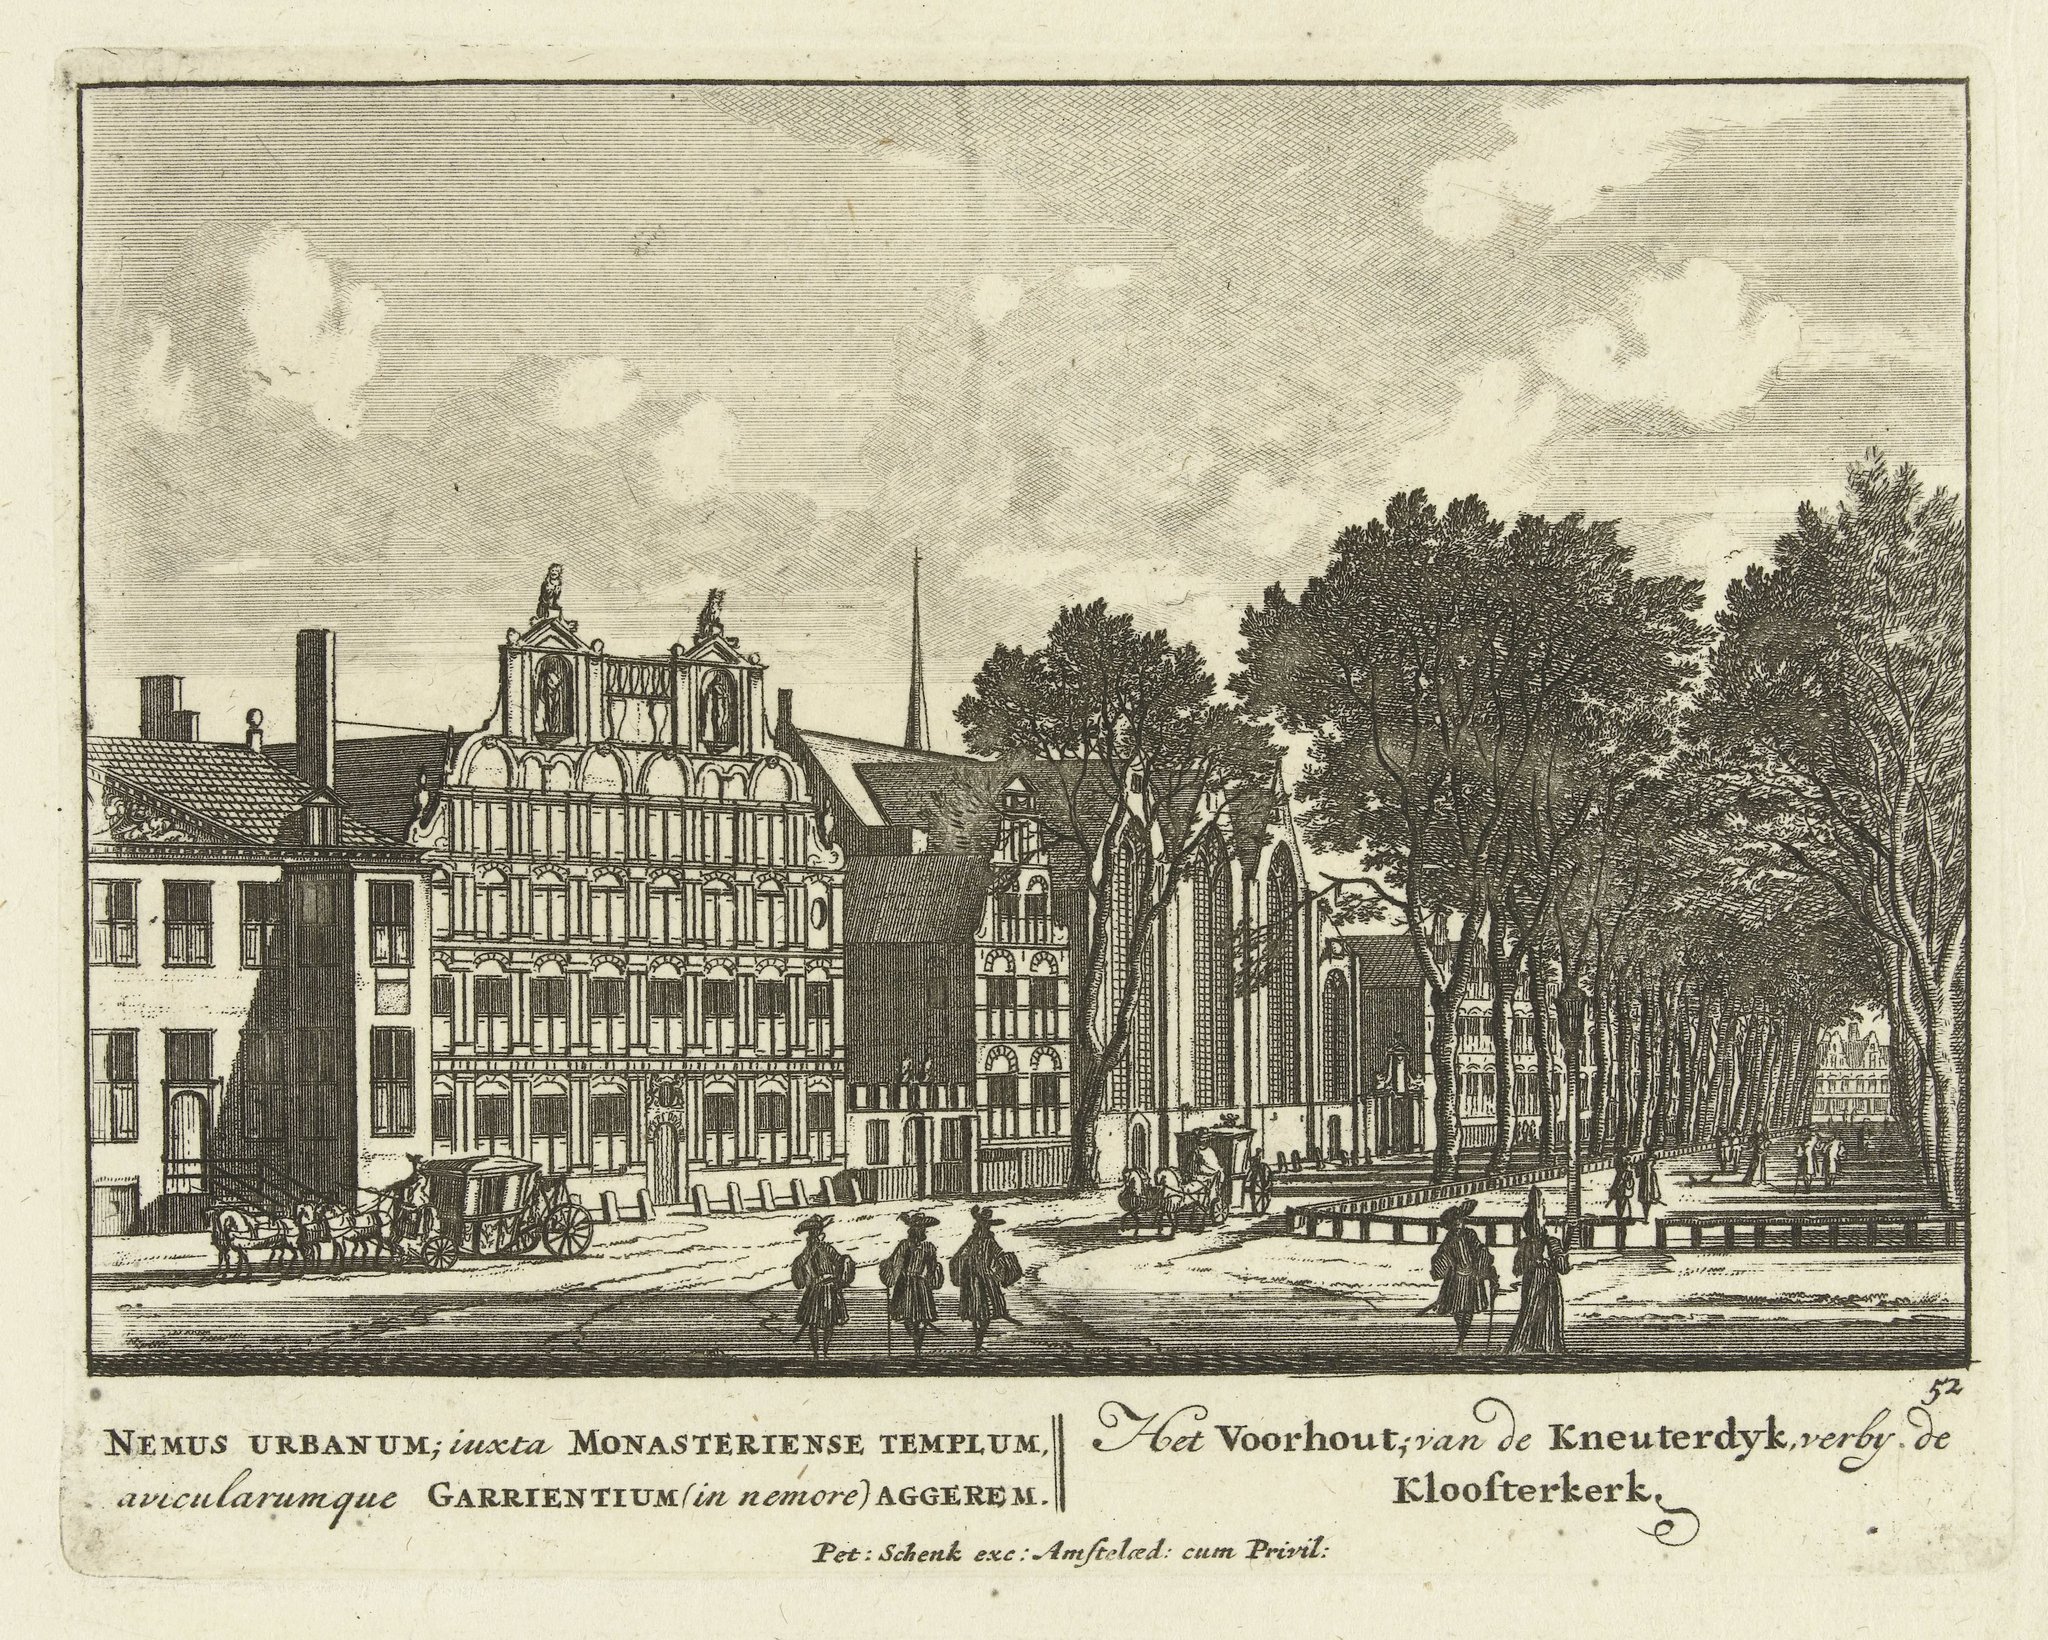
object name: print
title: Vermakelijke Gesigten van het overschone 's-Gravenhage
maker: pieter schenk (i)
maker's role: print maker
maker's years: 1660-1711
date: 1695-1705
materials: paper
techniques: etching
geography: amsterdam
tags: avenue, boulevard, promenade, esplanade, the hague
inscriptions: collector's mark: Lugt 2228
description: Prent uit een serie van 71 prenten met Rijnlandschappen, gezichten op vorstelijke paleizen en stadsgezichten uit Den Haag en Amsterdam.